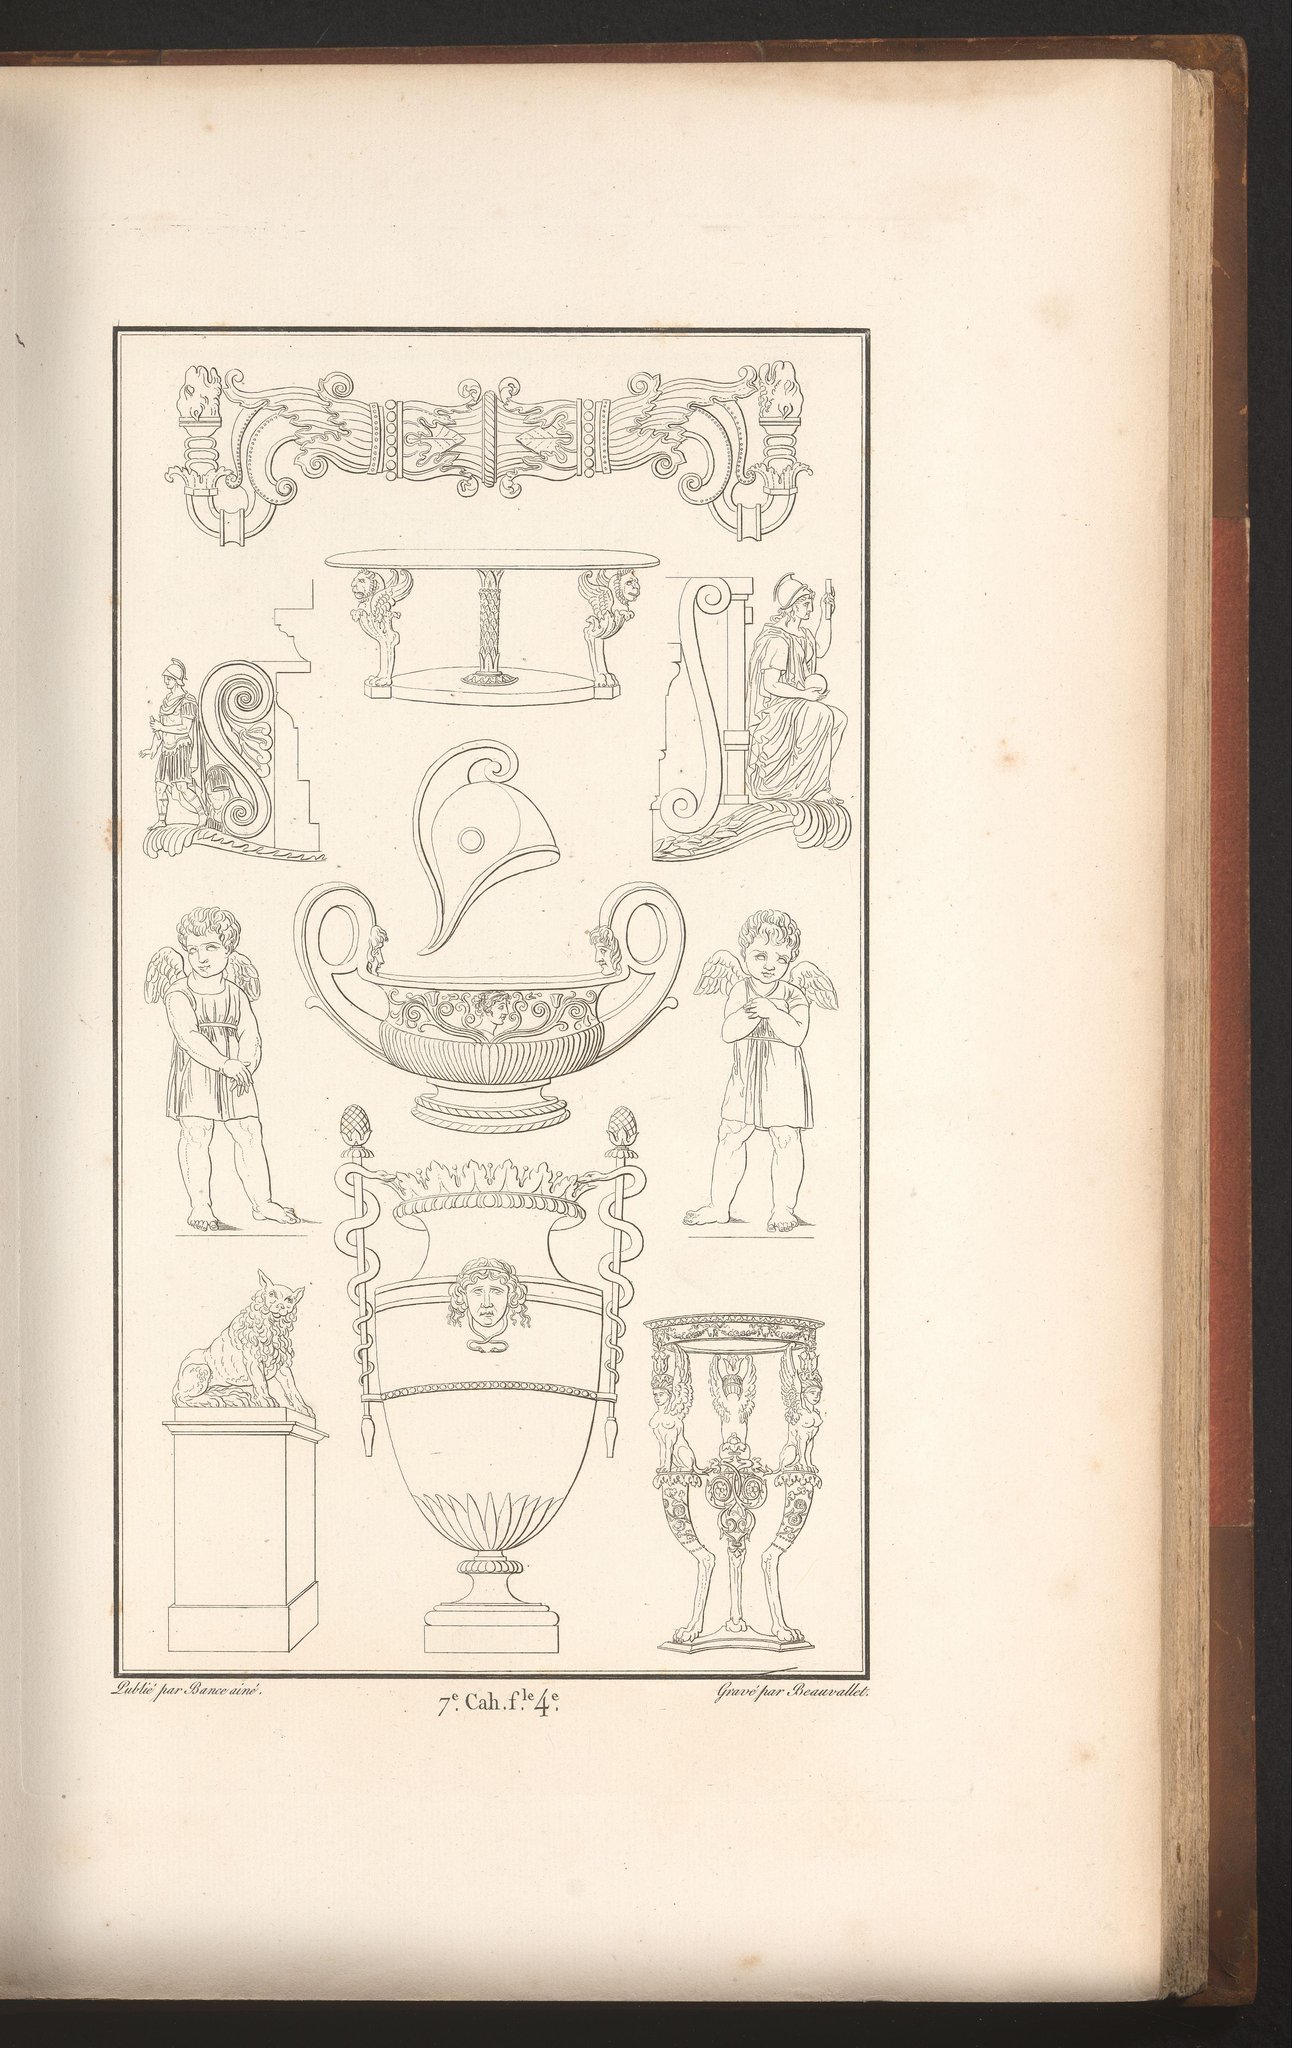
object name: ornament print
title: Diverse ornamenten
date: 1820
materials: paper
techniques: etching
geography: paris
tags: ornaments ~ art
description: Ornamentprent met diverse objecten, vazen, schalen en figuren. Onderdeel (7e. Cah. f.le 41) van het prentalbum met twee series van in totaal 138 ornamentprenten door Beauvallet en Normand, 'Fragmens d'Ornemens dans le Style Antique'.